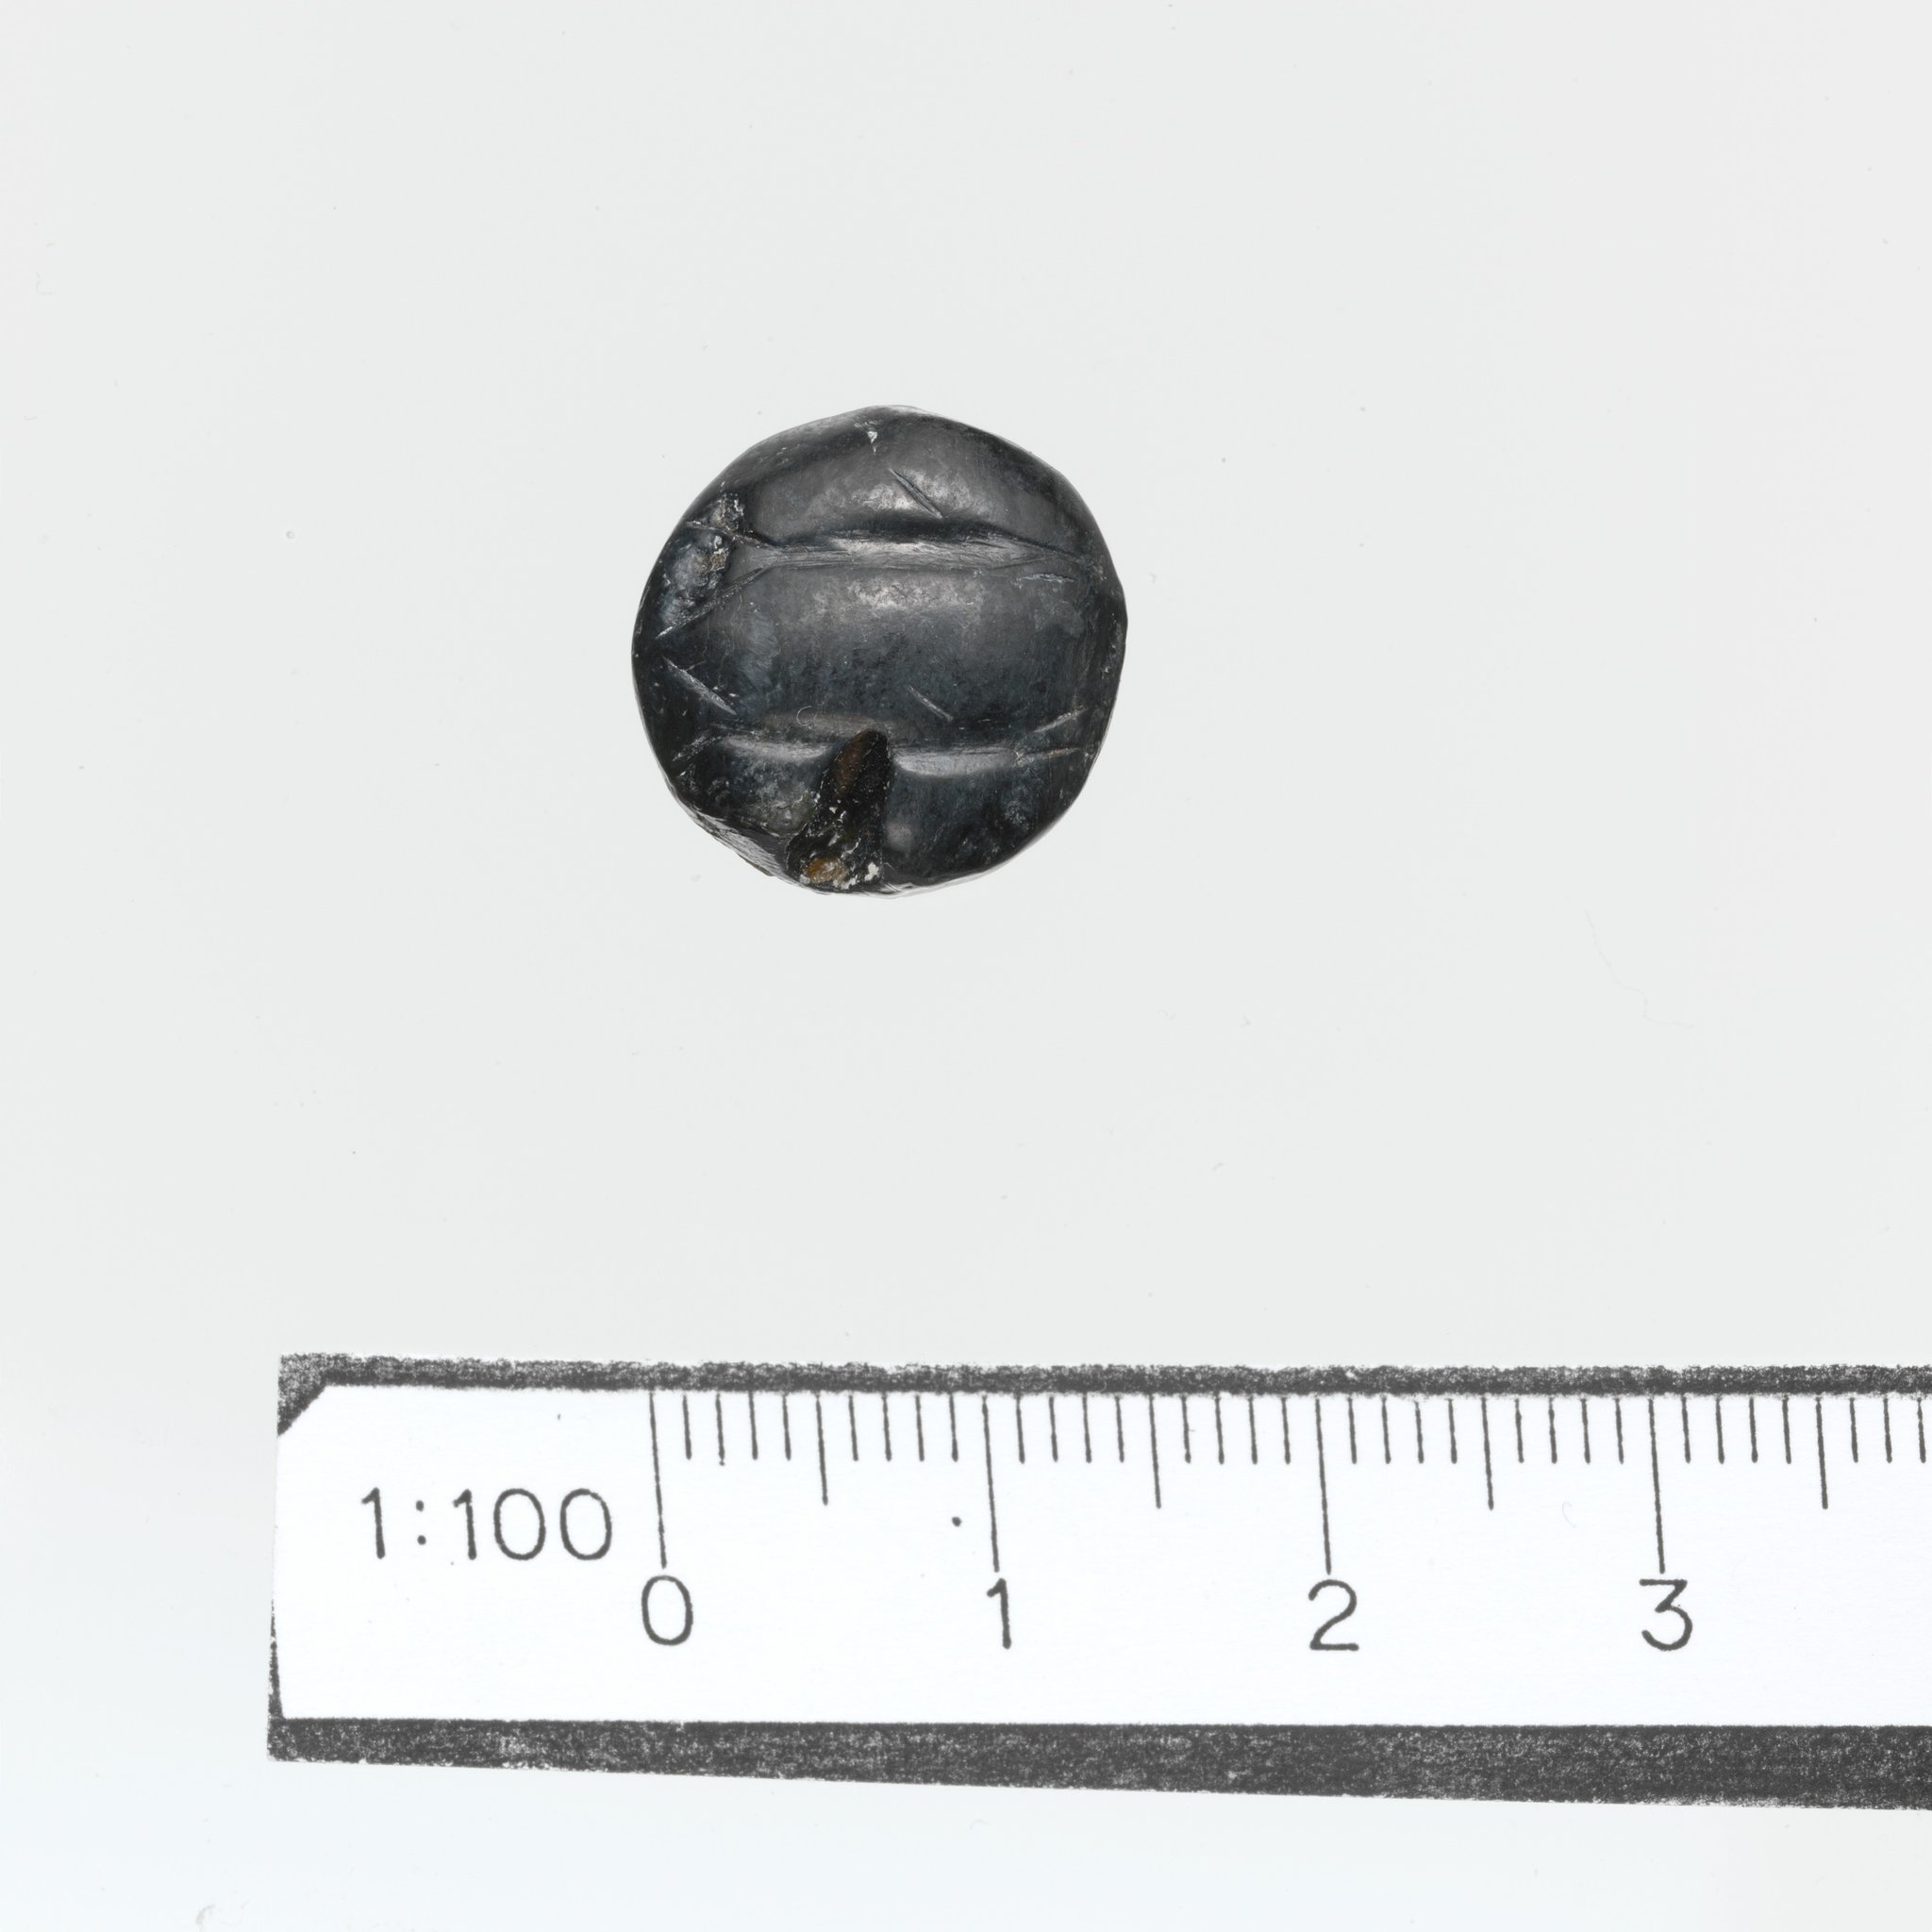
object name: seal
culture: minoan, crete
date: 2000-1450 BCE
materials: jasper